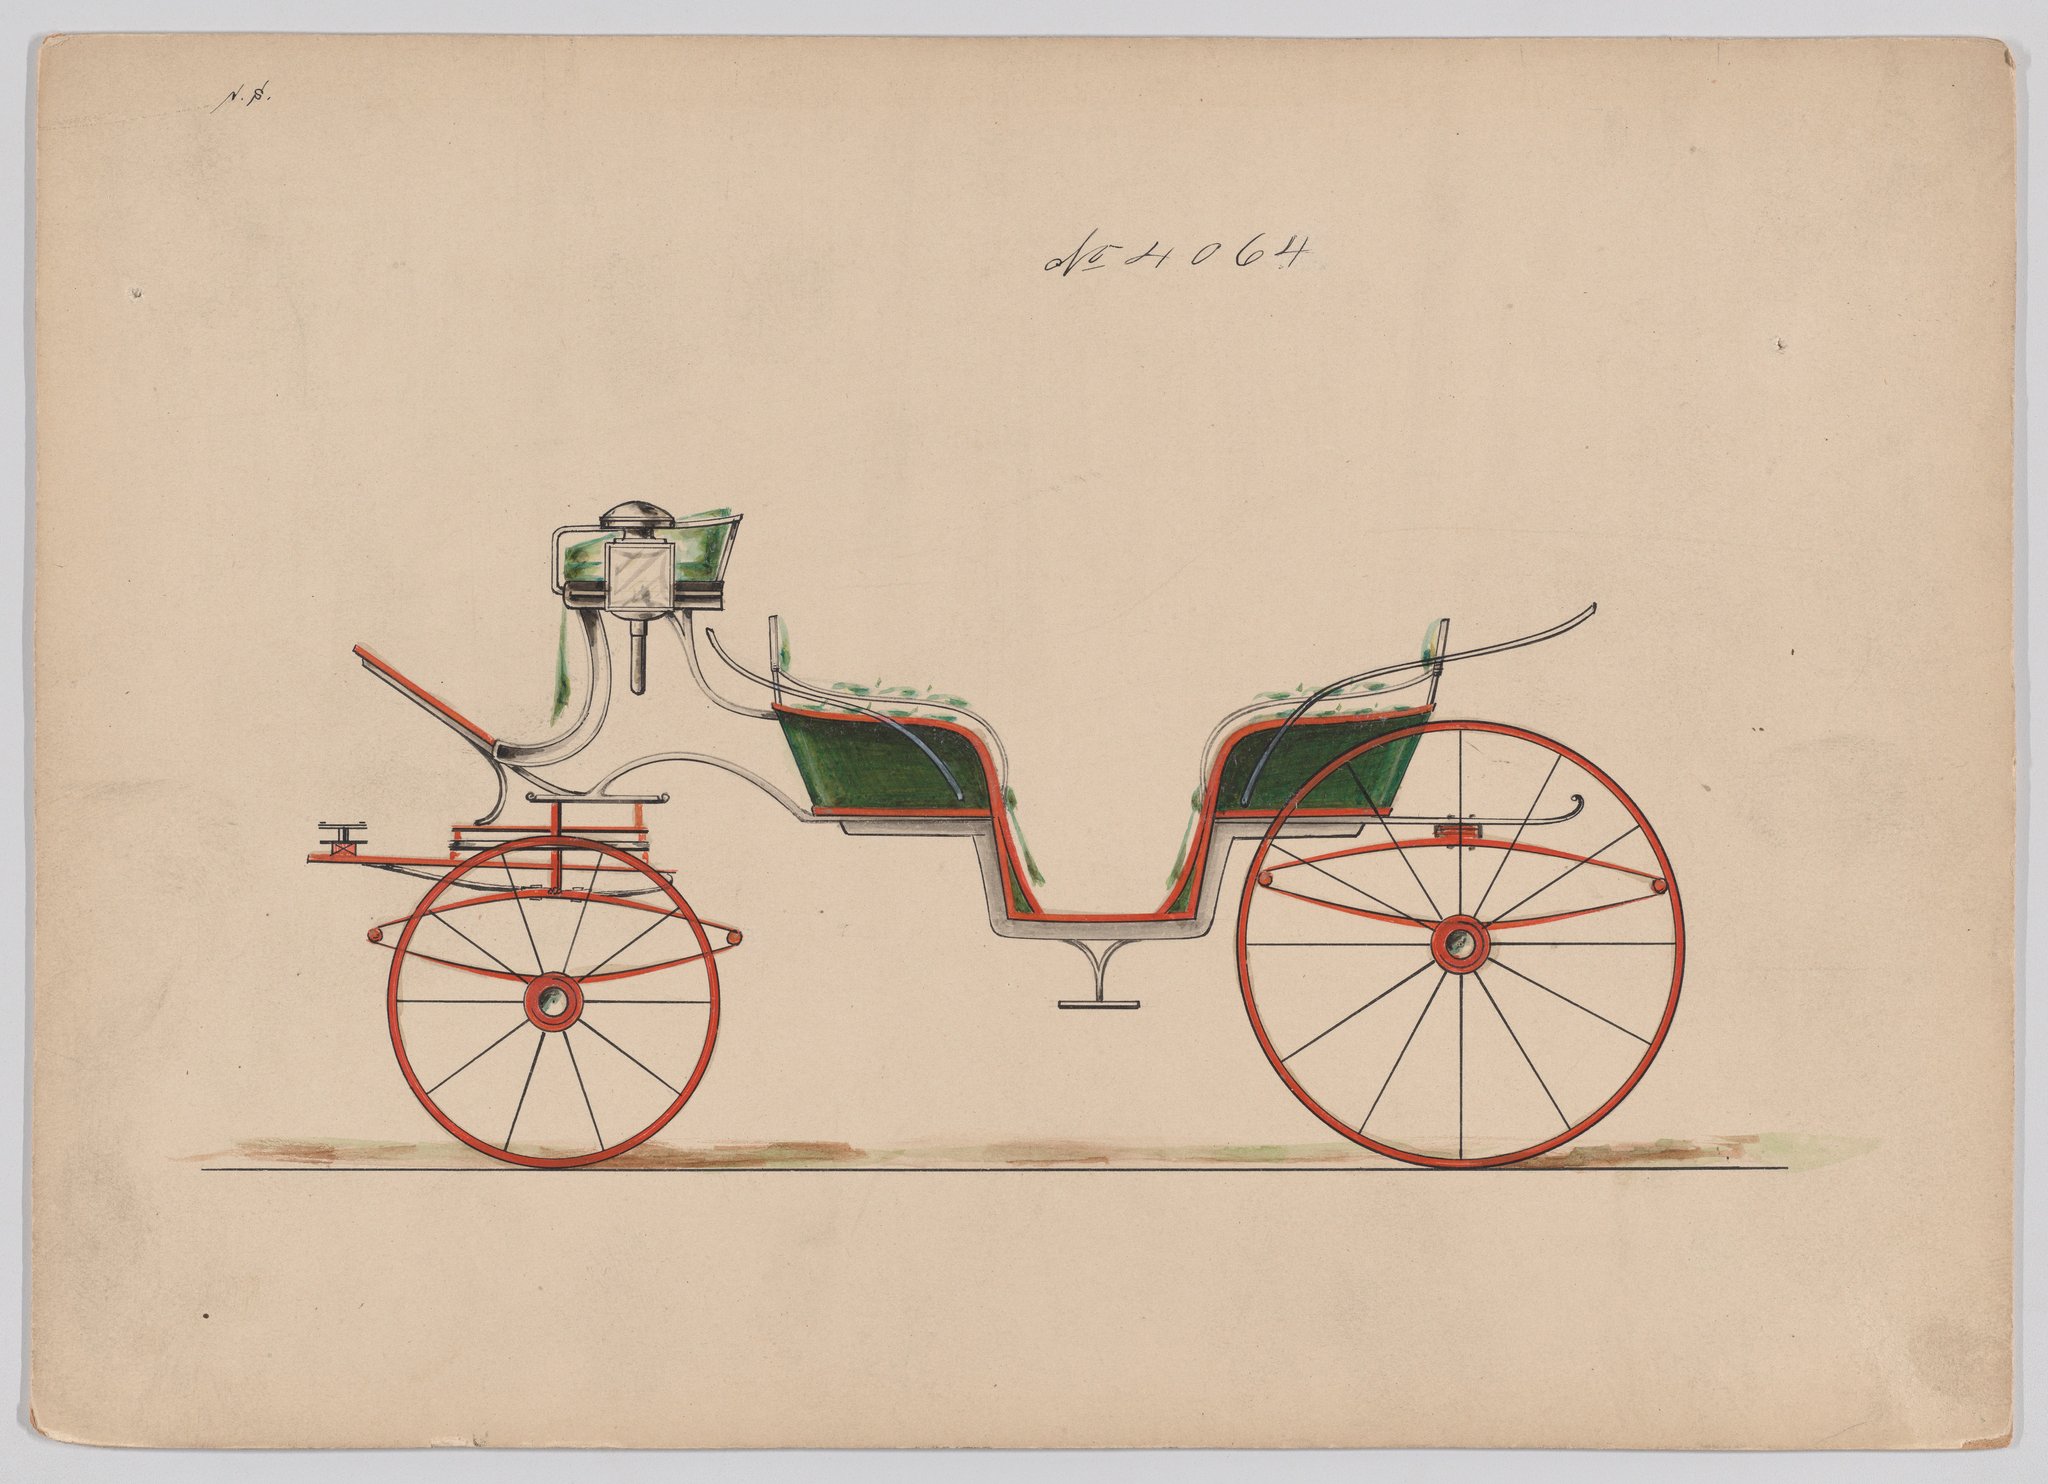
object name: drawing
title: Vis-a-Vis # 4064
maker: brewster & co.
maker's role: manufacturer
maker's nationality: american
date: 1890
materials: gouache, gum arabic, ink, watercolor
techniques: pen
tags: carriages